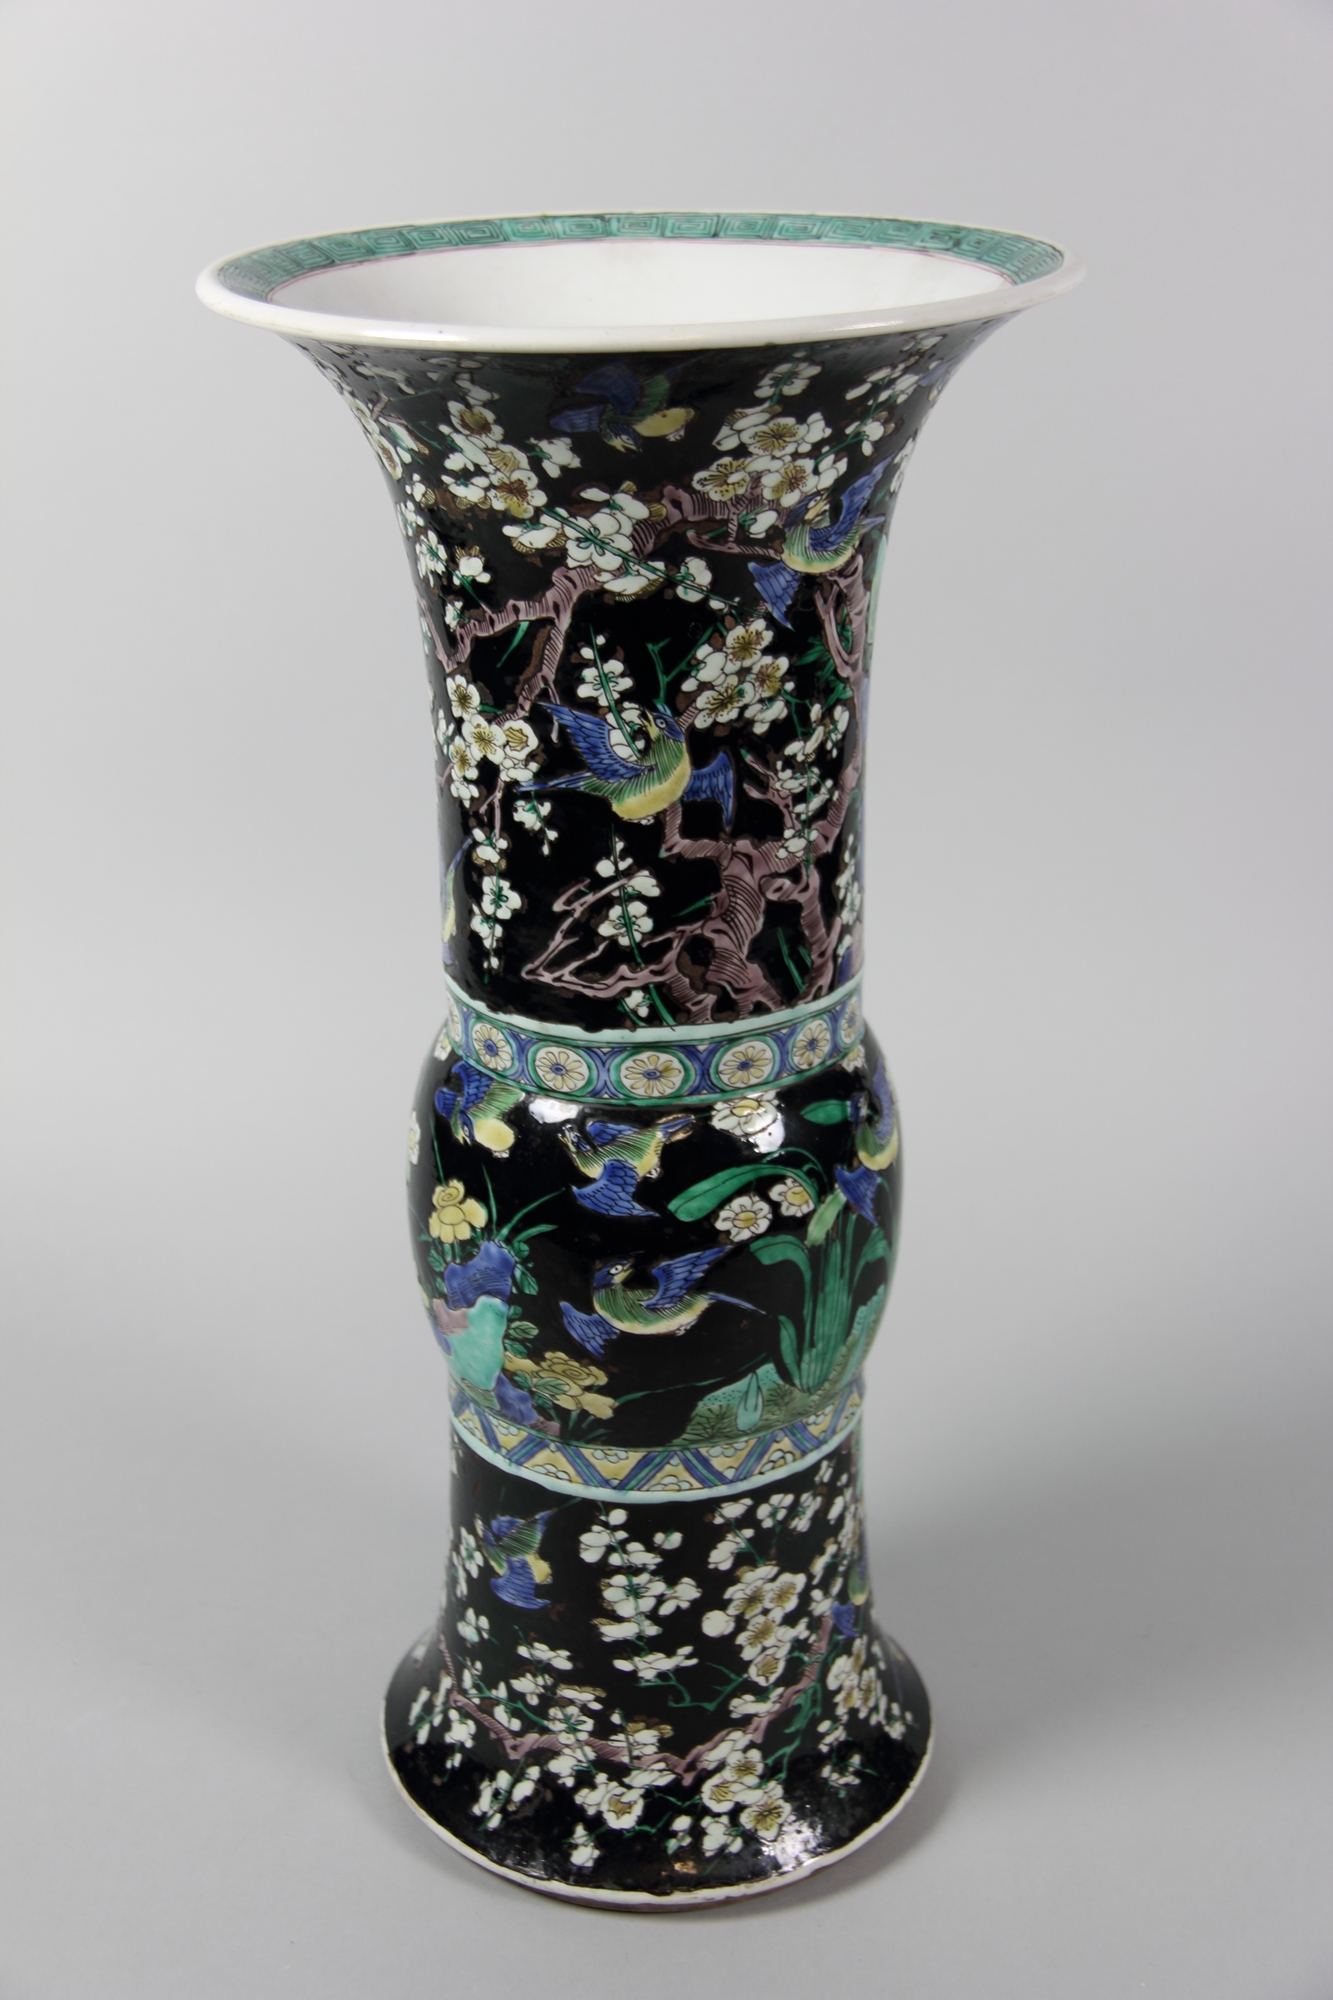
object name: vase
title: Vase with birds and flowers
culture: chinese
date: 1801-1900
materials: enamel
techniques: painting, polychrome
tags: birds,flowers